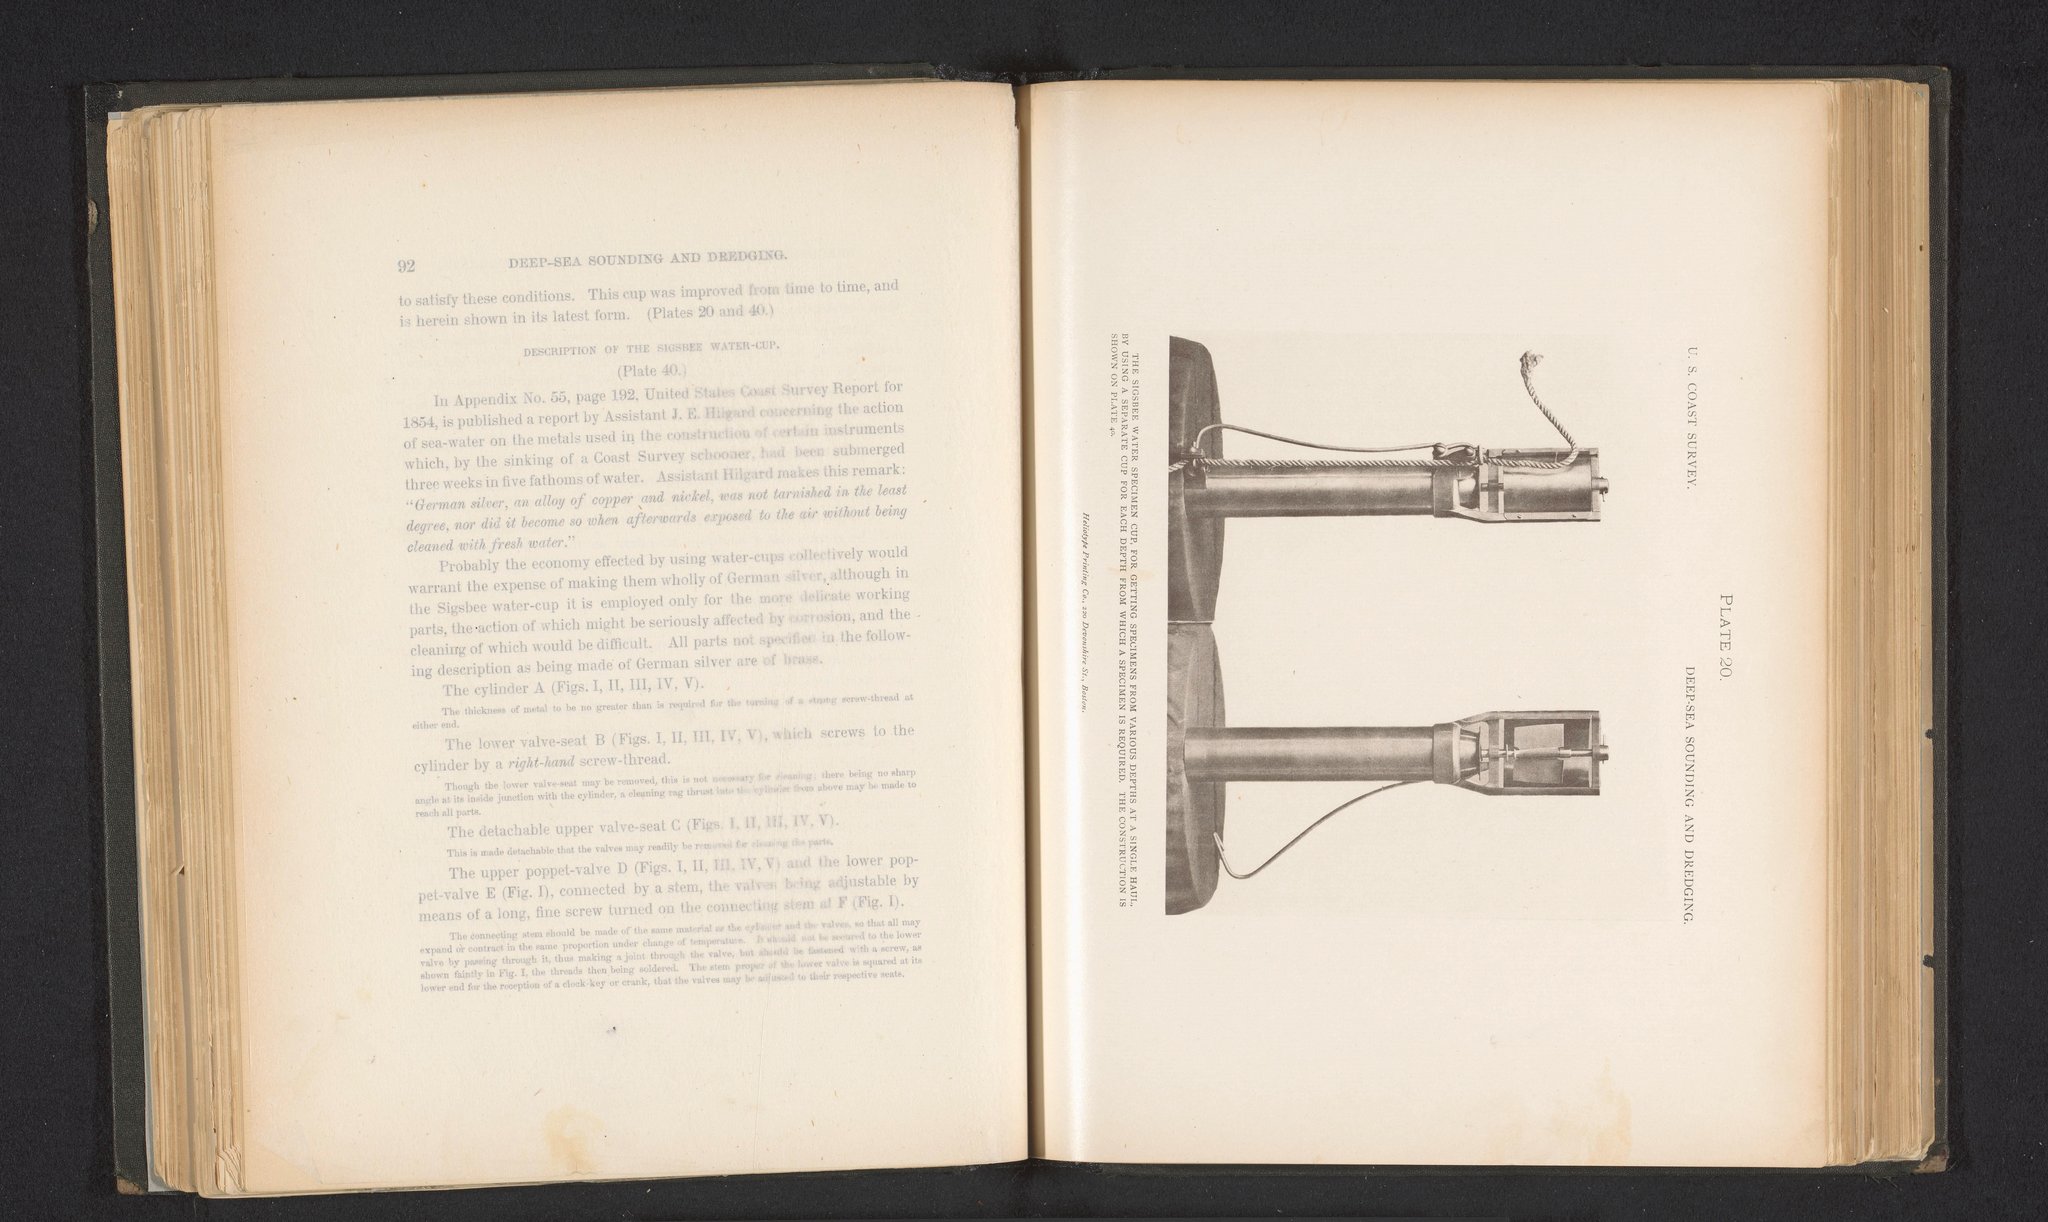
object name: page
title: Twee aanzichten van een watermonstervat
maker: Anonymous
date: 1870-1880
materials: paper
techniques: photograph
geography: united states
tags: cup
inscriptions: inscription: ‘The Sigsbee water specimen cup for getting specimens from various depths at a single haul. By using a seperate cup for each from which a specimen is required. The construction is shown on plate 40.’, number: ‘Plate 20.’, name: ‘Heliotype Printing Co., 220 Devonshire St., Boston.’